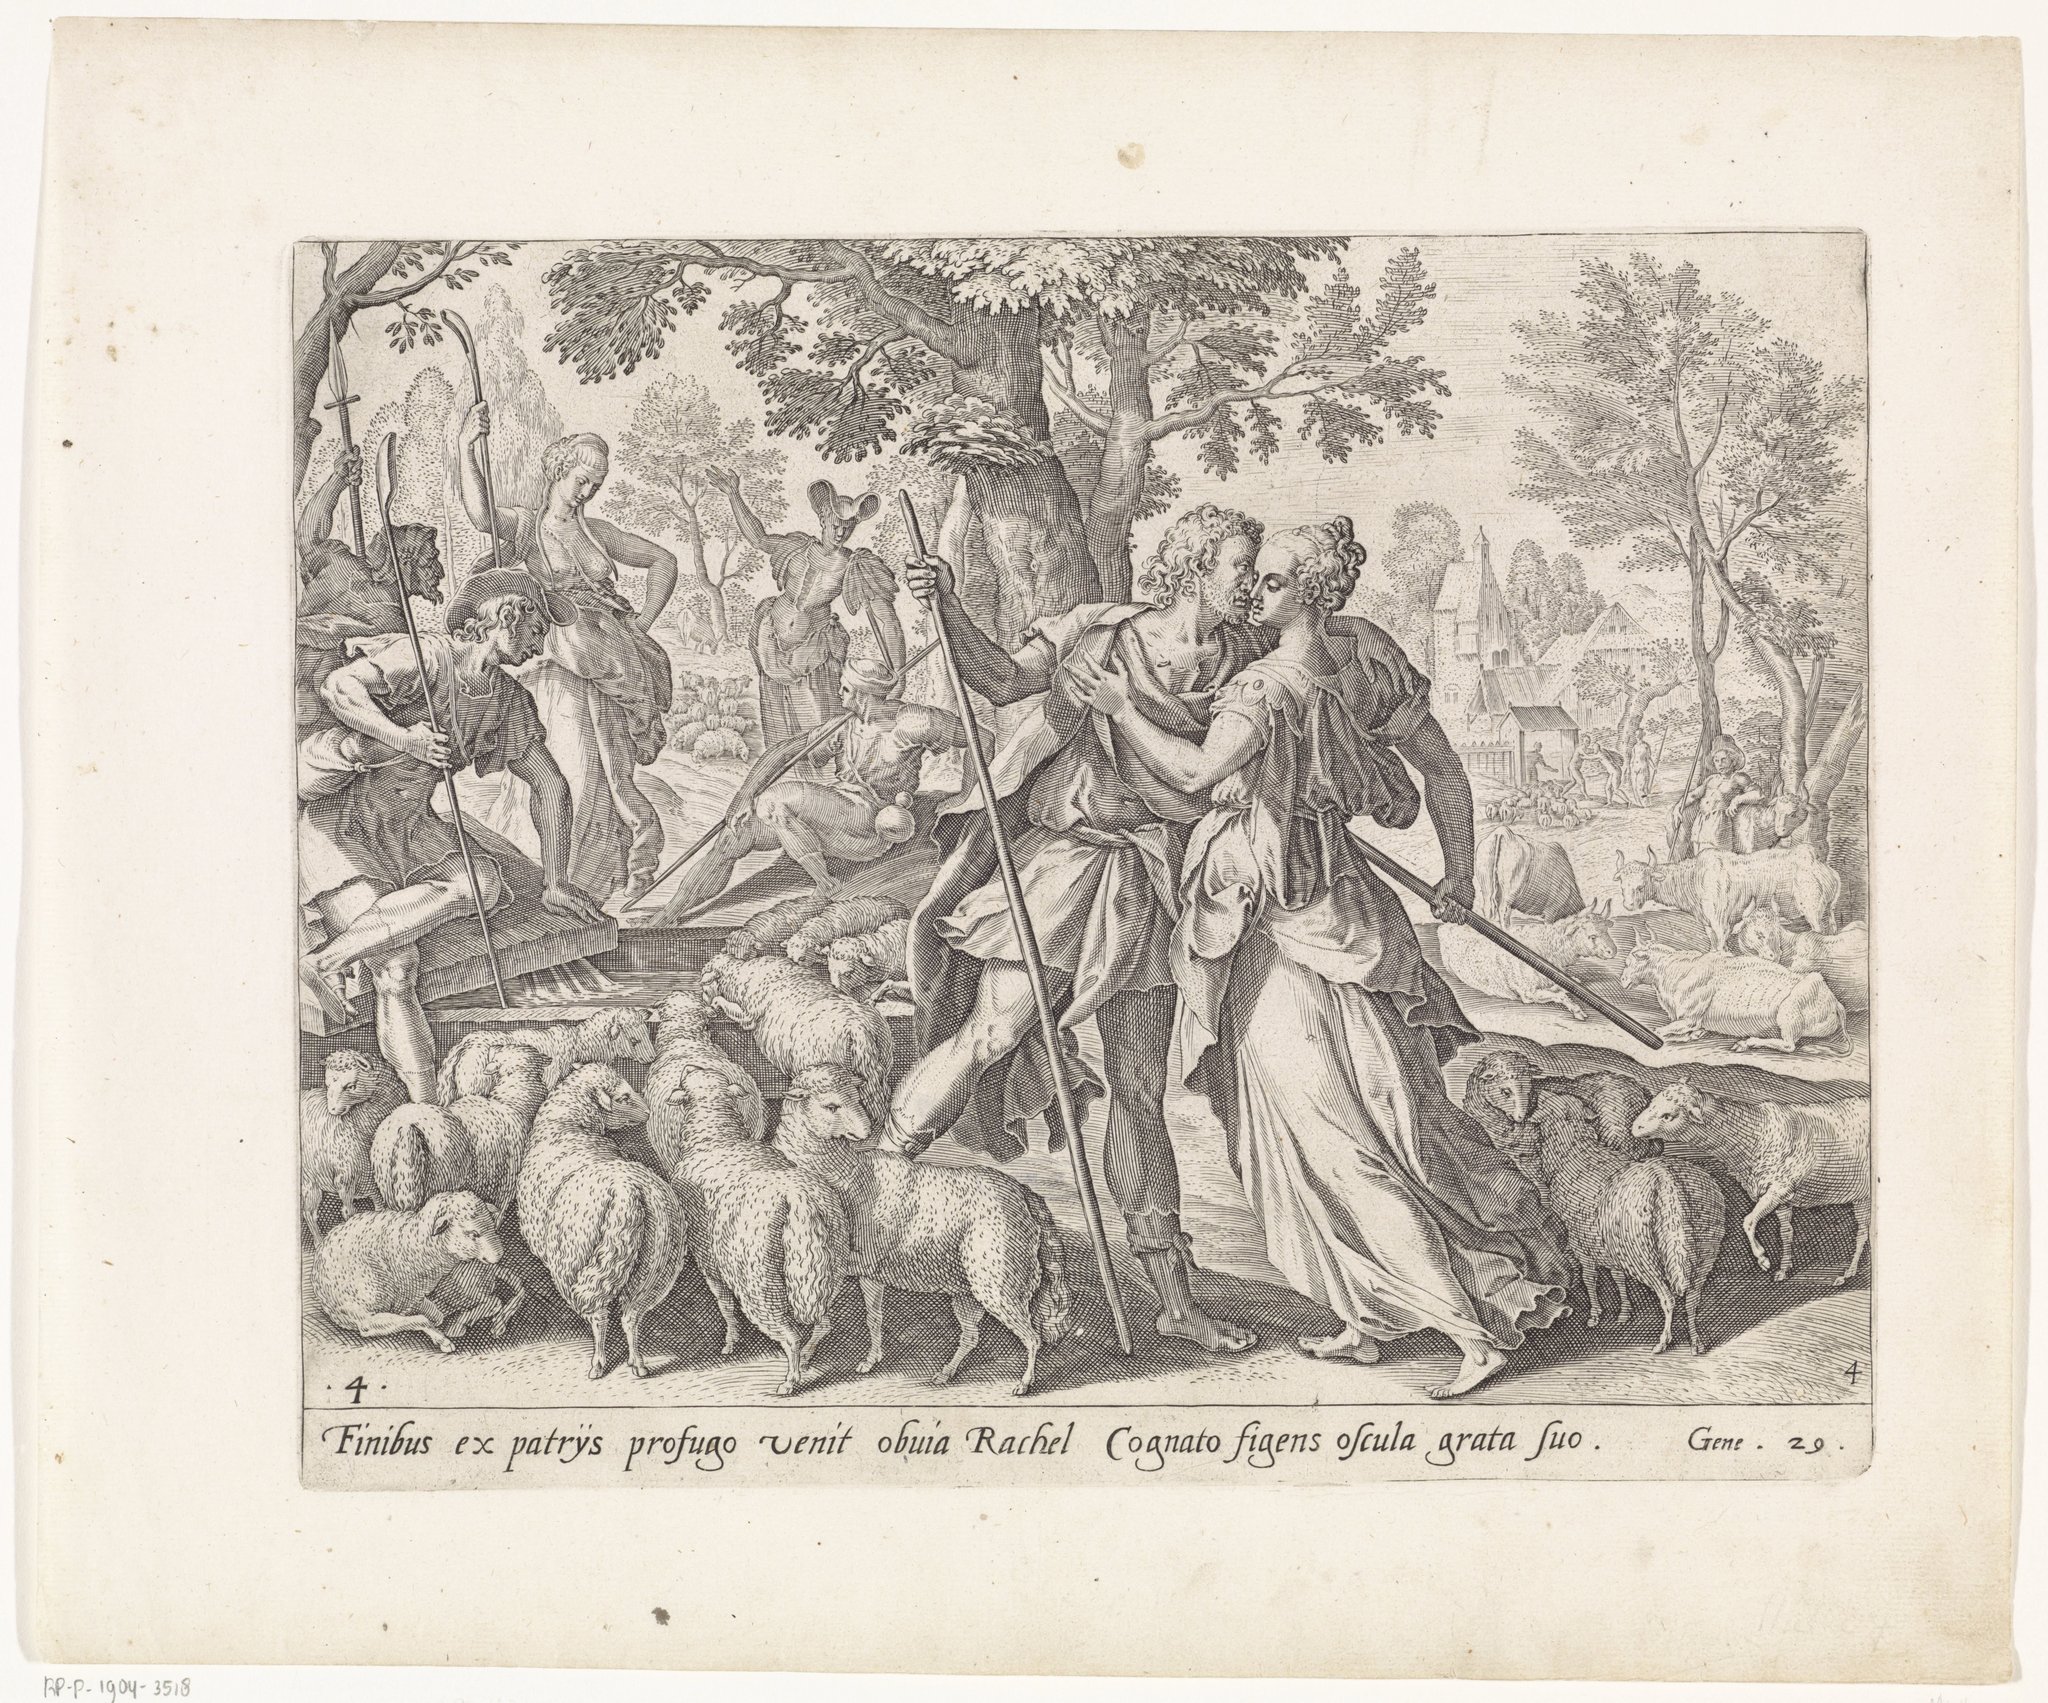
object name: print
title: Jakob ontmoet Rachel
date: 1579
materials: paper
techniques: engraving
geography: amsterdam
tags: jacob kisses rachel and is moved to tears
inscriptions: collector's mark: Lugt 2228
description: Prent gebruikt in: Theatrum biblicum : hoc est historiae sacrae veteris et novi testamenti tabulis aeneis expressae. Opus praesentatissimorum huius ac superioris seculi pictorum atque sculptorum, summo studio conquisitum et in lucem editum. Amsterdam: Claes Jansz. Visscher, 1643.